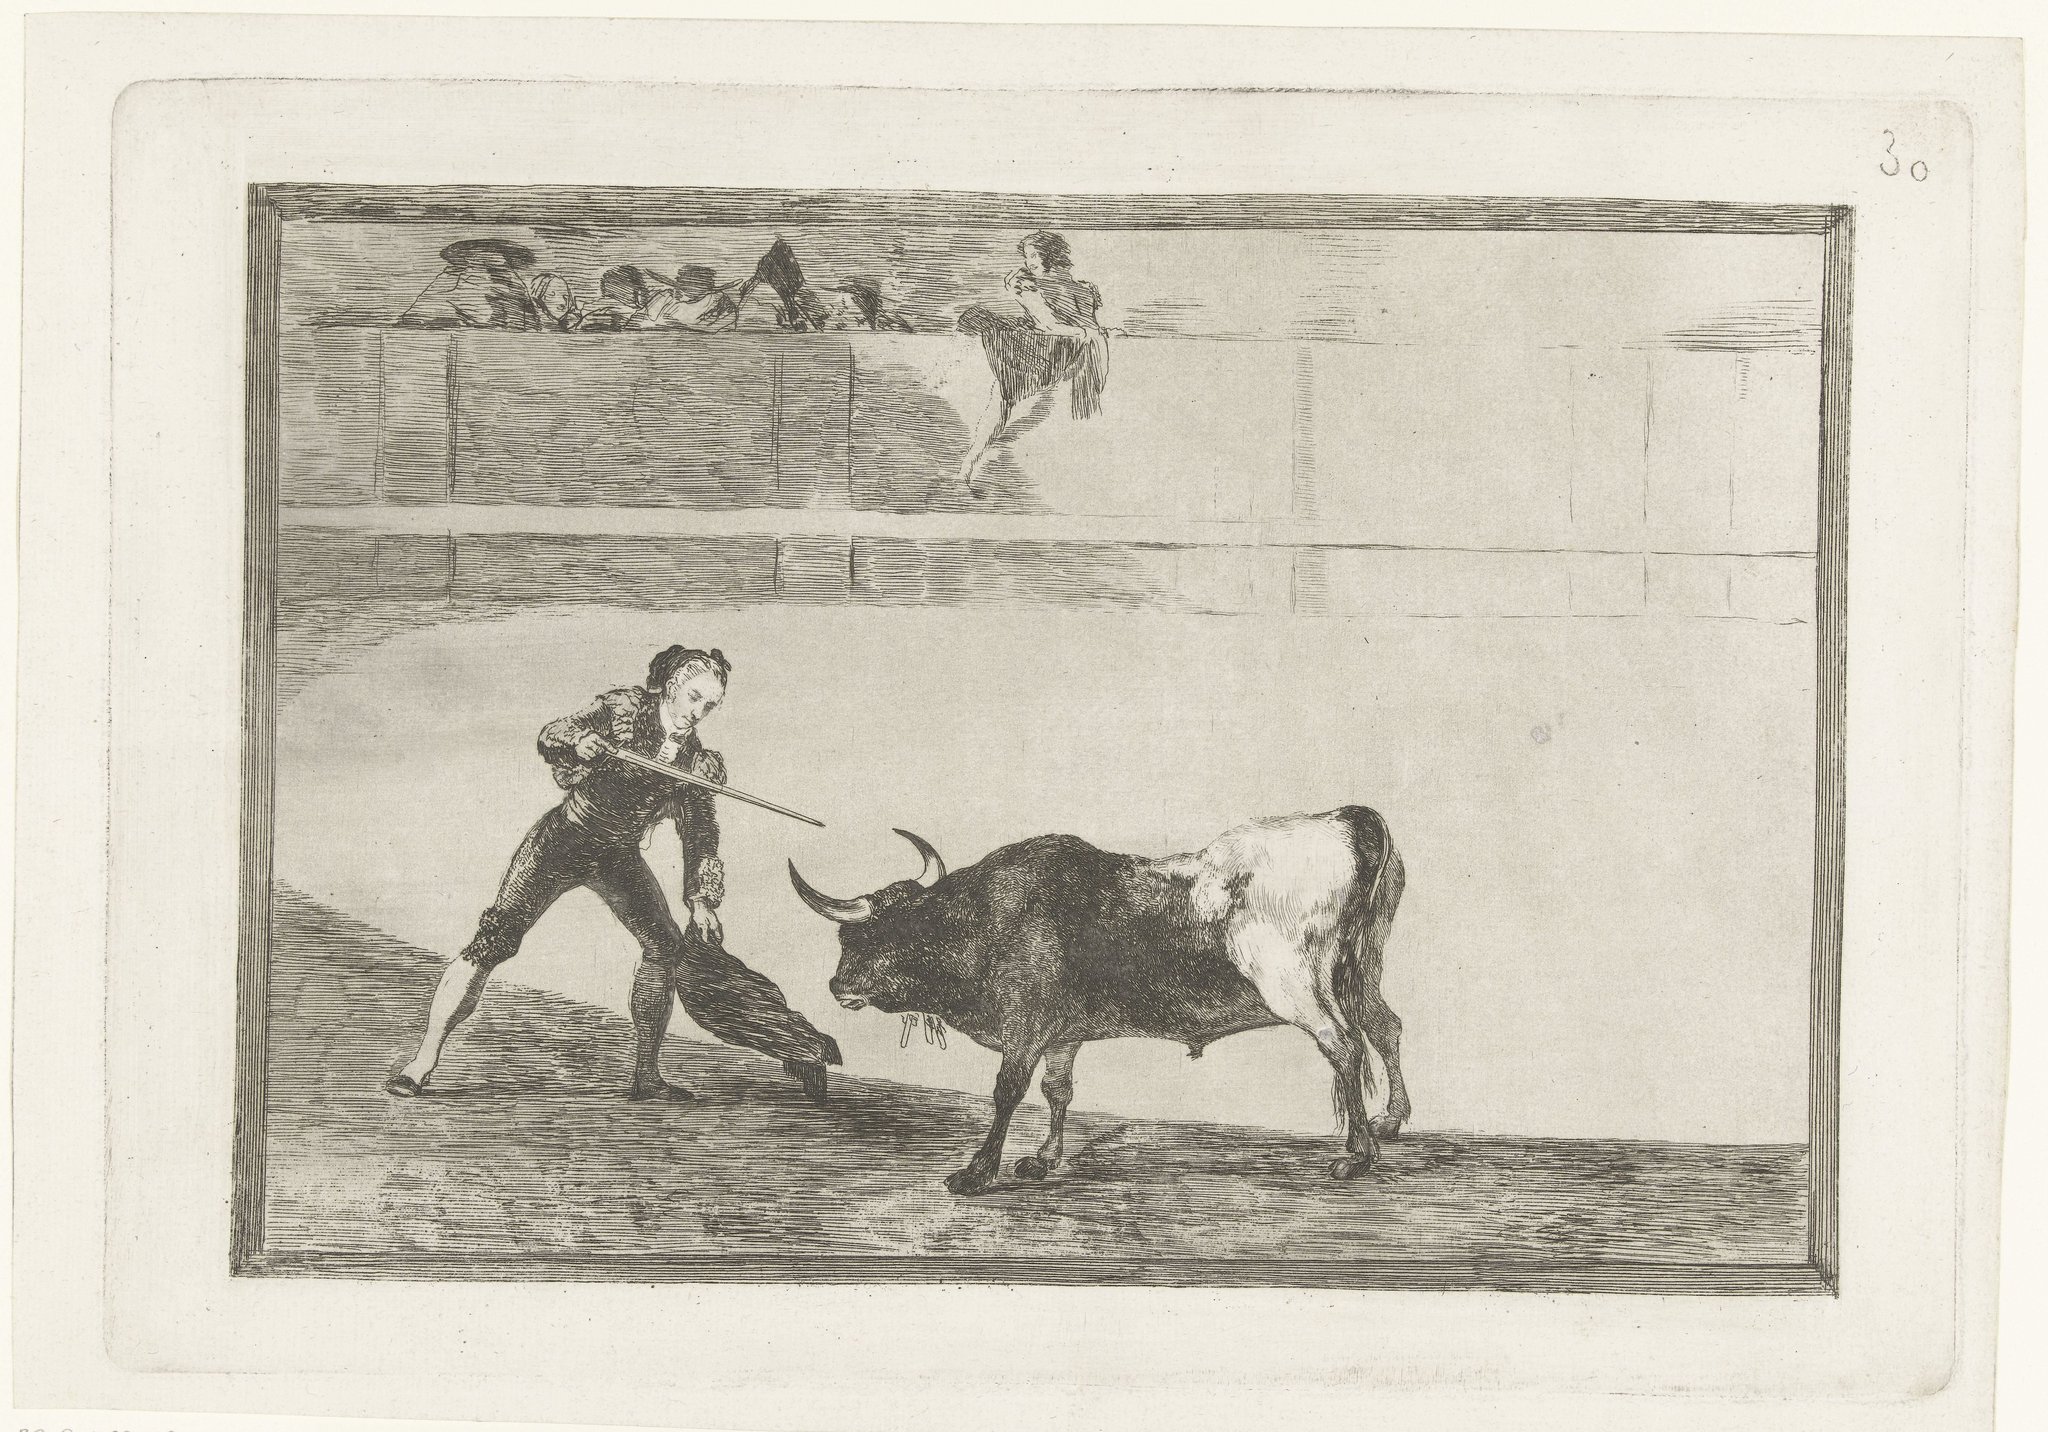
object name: print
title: Pedro Romero matando á toro parado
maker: francisco de goya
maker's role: draughtsman, painter, print maker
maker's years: 1746-1828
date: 1811-1816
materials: paper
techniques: aquatint, drypoint, etching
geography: spain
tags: bullfight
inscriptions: collector's mark: Lugt 2228, collector's mark: Lugt 805b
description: De torero (stierenvechter) Pedro Romera Martínez in de arena, staand tegenover de stier. Een cape in zijn linkerhand, zijn zwaard uitgestoken richting het dier.